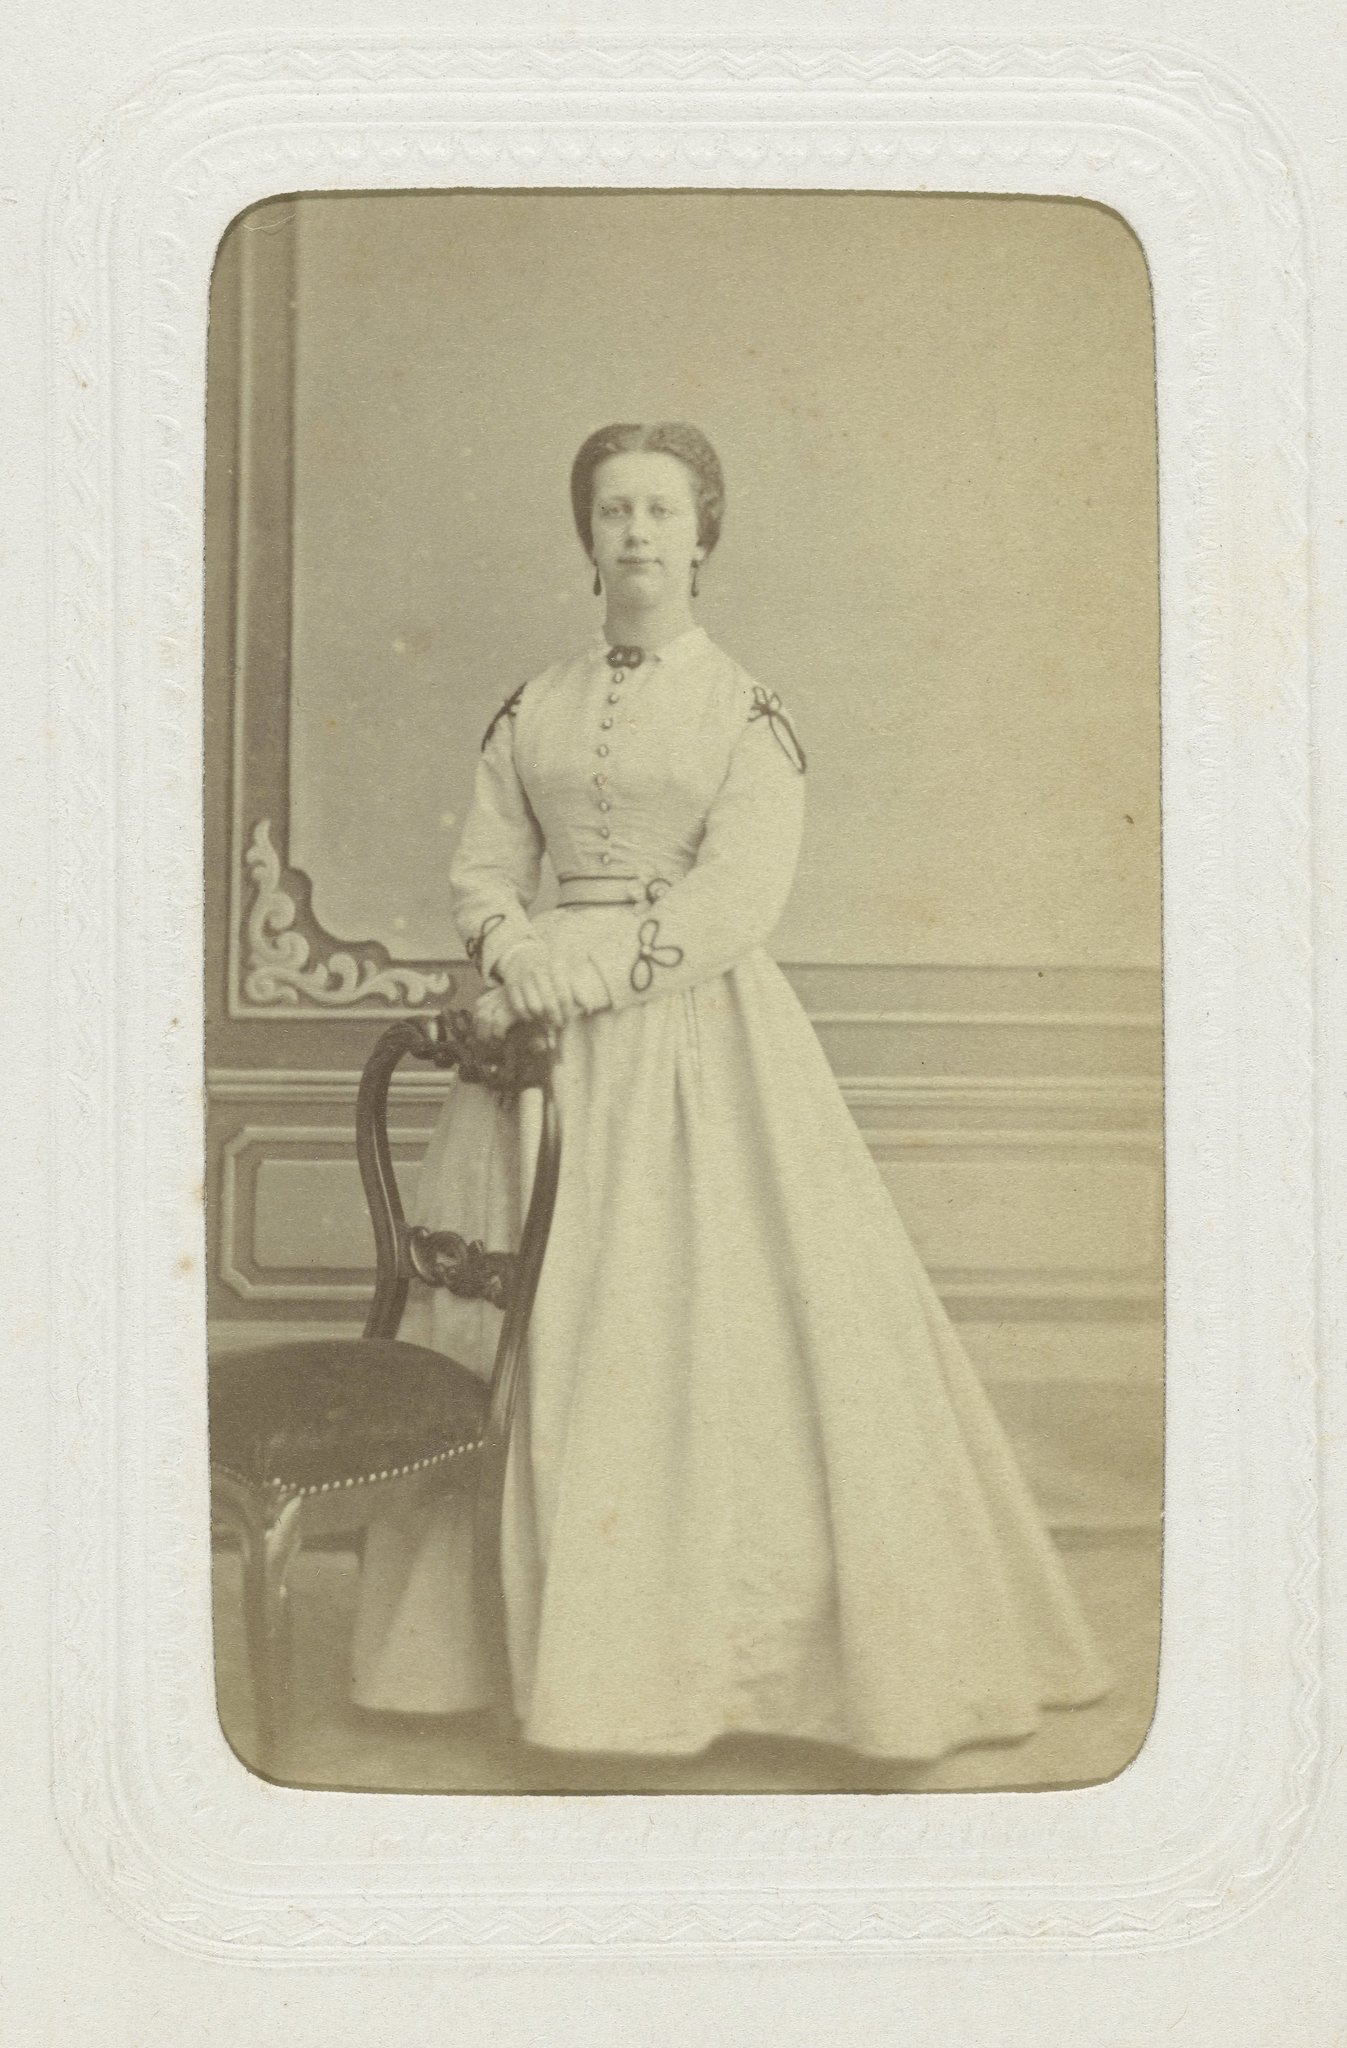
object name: carte de visite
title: Studioportret van een vrouw in een hooggesloten witte jurk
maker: kornelis willem schorteldoek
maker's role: boekbinder, fotograaf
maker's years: 1800-1885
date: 1863-1866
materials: cardboard, paper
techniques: albumen print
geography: gorinchem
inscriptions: name: ‘Schorteldoek, Gorinchem’